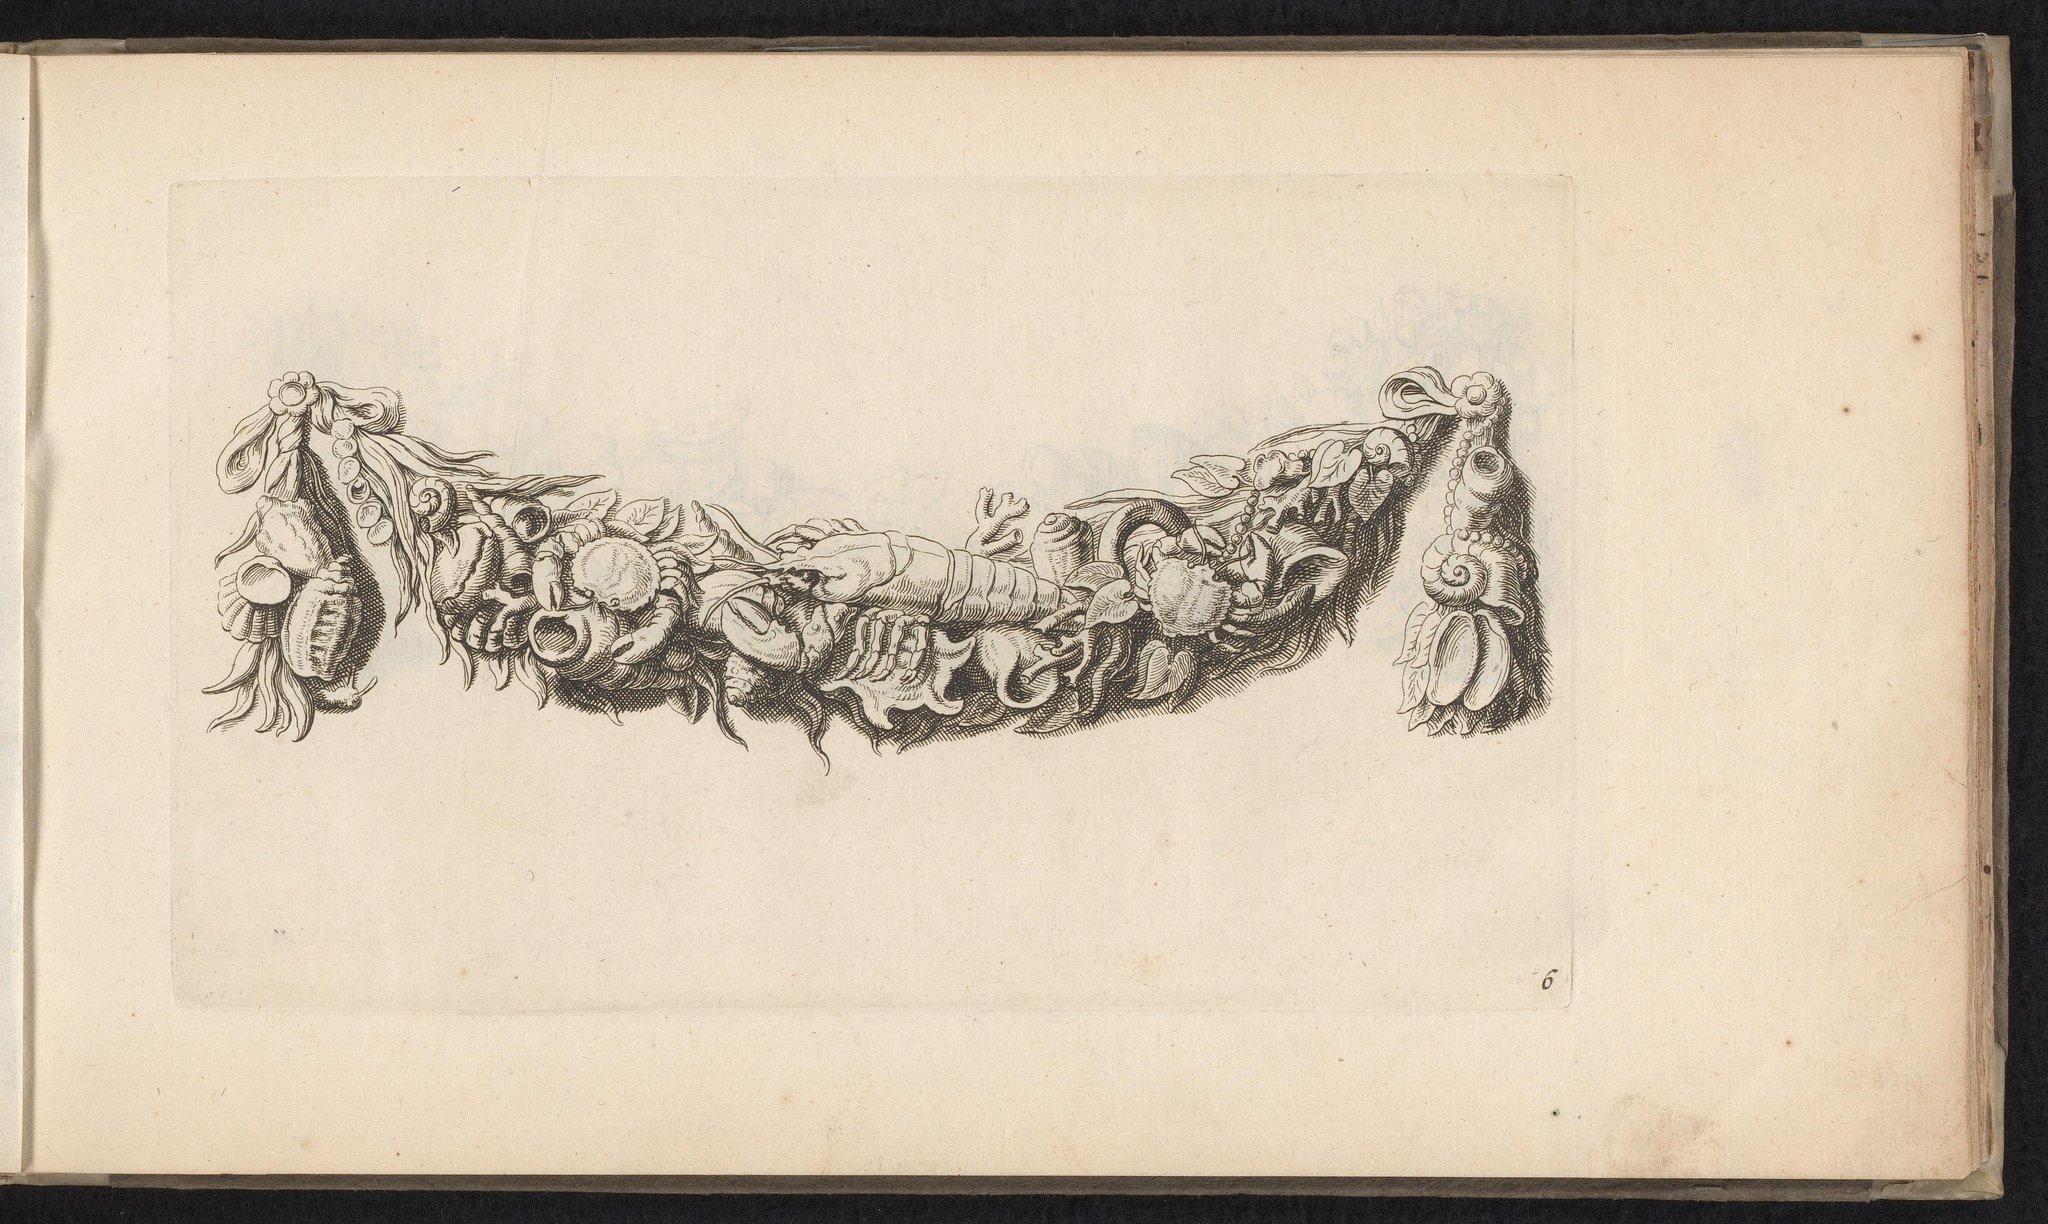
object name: ornament print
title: Festoen van krabben en kreeften uit het stadhuis van Amsterdam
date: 1665-1685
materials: ink, paper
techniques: etching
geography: amsterdam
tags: crustaceans: crab, ornament ~ festoon, garland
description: Prent uit elf genummerde prenten met festoenen. Kopieën in dezelfde richting naar de prenten in Artus Quellinus, Prima Pars Praecipuarium (…), Amsterdam 1665. Gebonden in 19de-eeuwse band met blauwe kaft en witte rug, genummerd: 3.